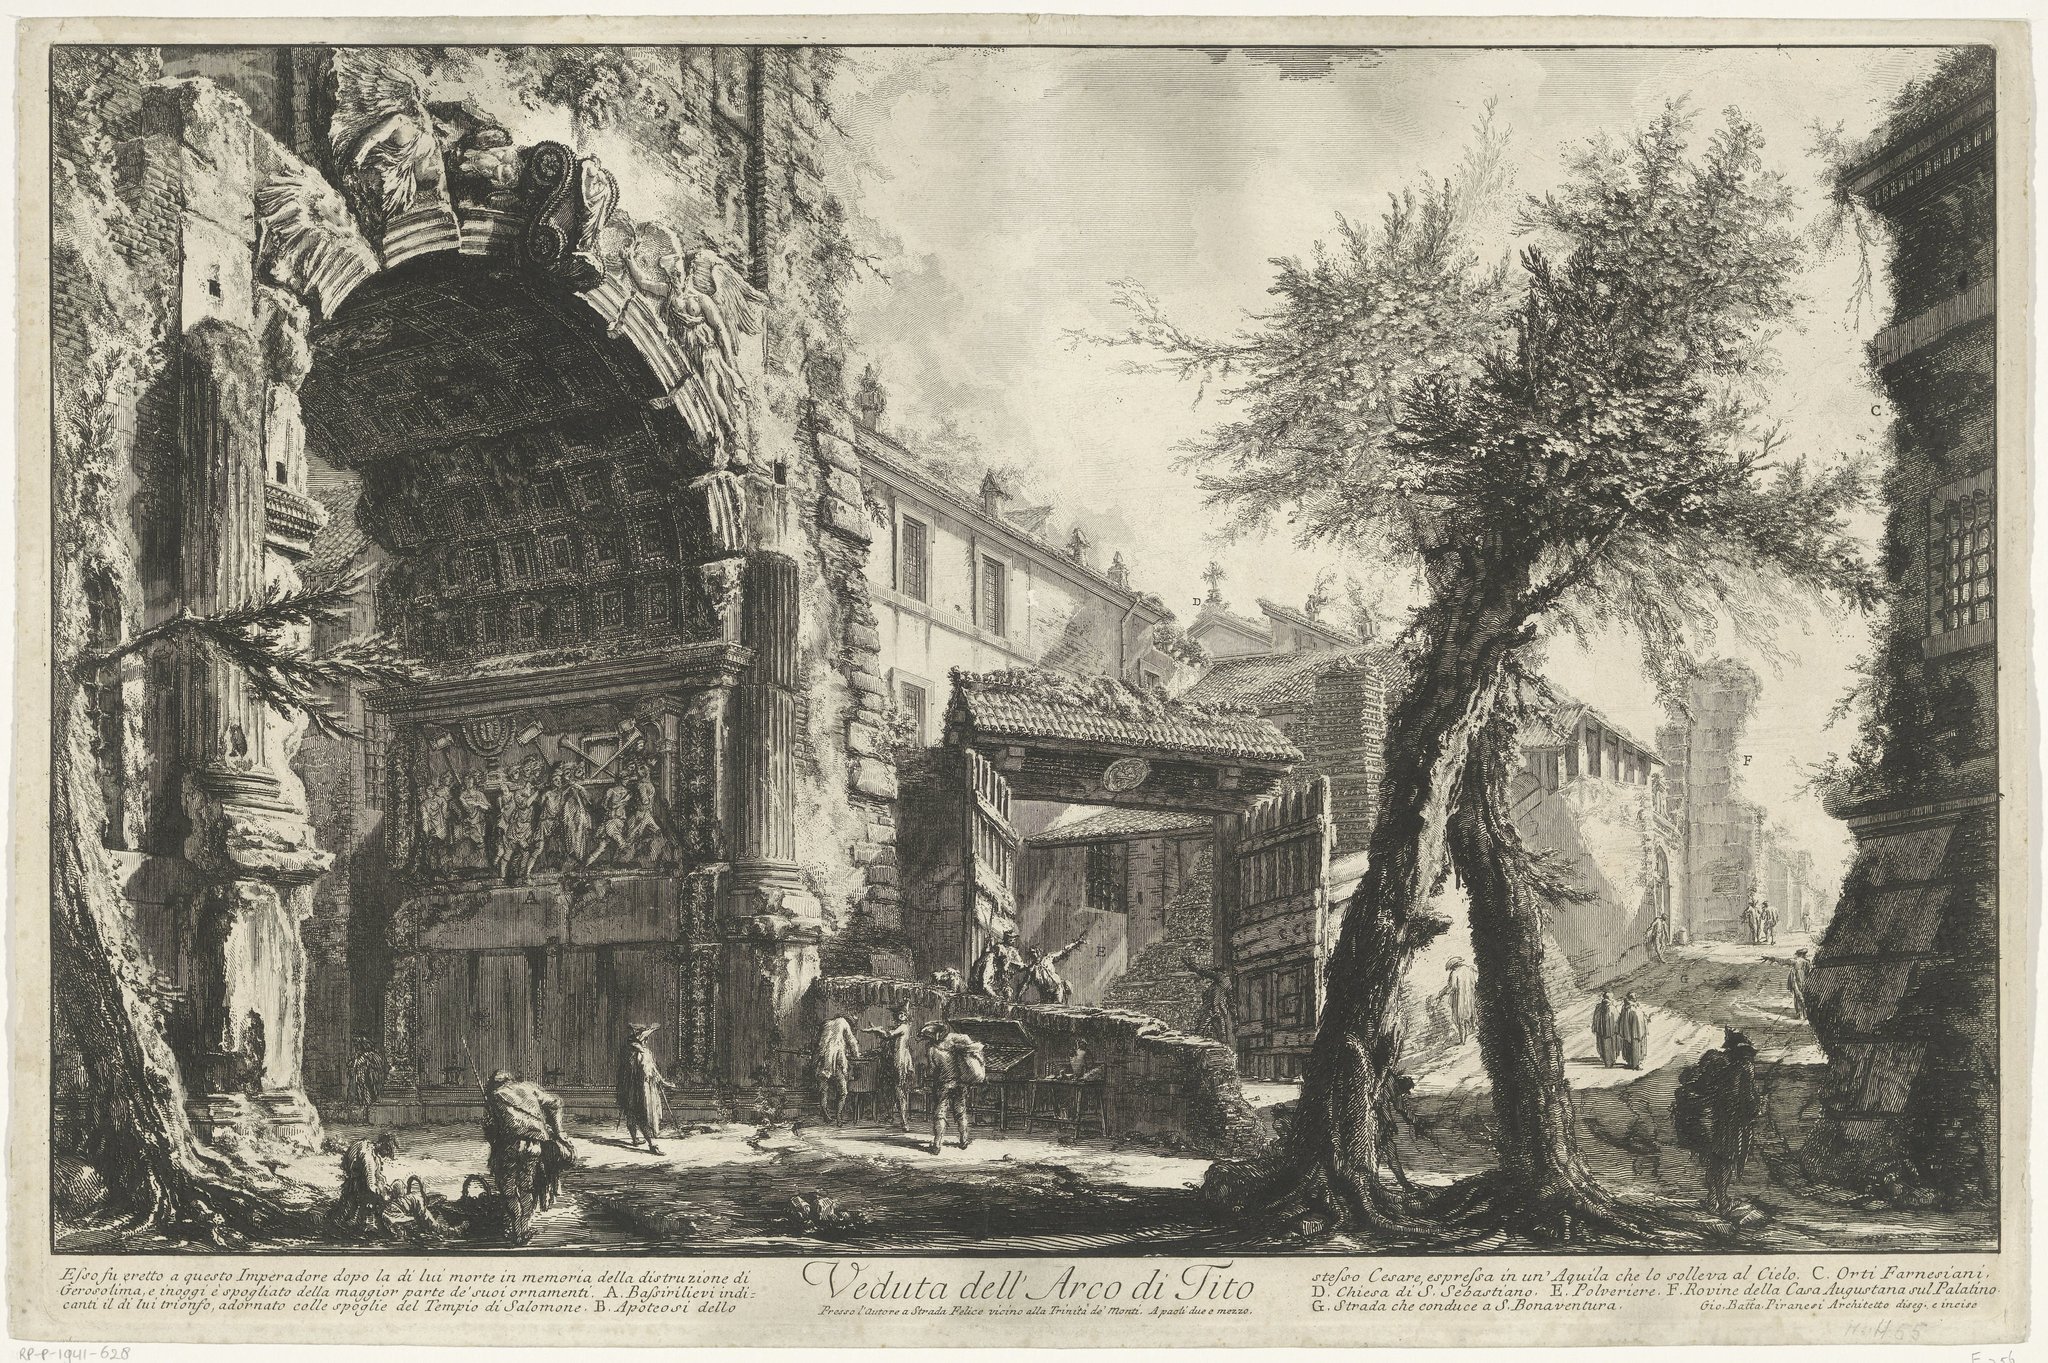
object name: print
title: Boog van Titus te Rome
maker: giovanni battista piranesi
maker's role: designer, draughtsman, print maker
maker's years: 1720-1778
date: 1748-1778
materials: paper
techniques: etching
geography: rome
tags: ruin of a building ~ architecture, triumphal arch, landscape with ruins, rome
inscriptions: collector's mark: Lugt 2228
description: Deze prent maakt deel uit van de serie 'Vedute di Roma'. Piranesi werkte aan deze 135 platen tellende serie tussen 1748 en zijn dood in 1778. Francesco Piranesi voegde later nog twee prenten toe aan de reeks van zijn vader.